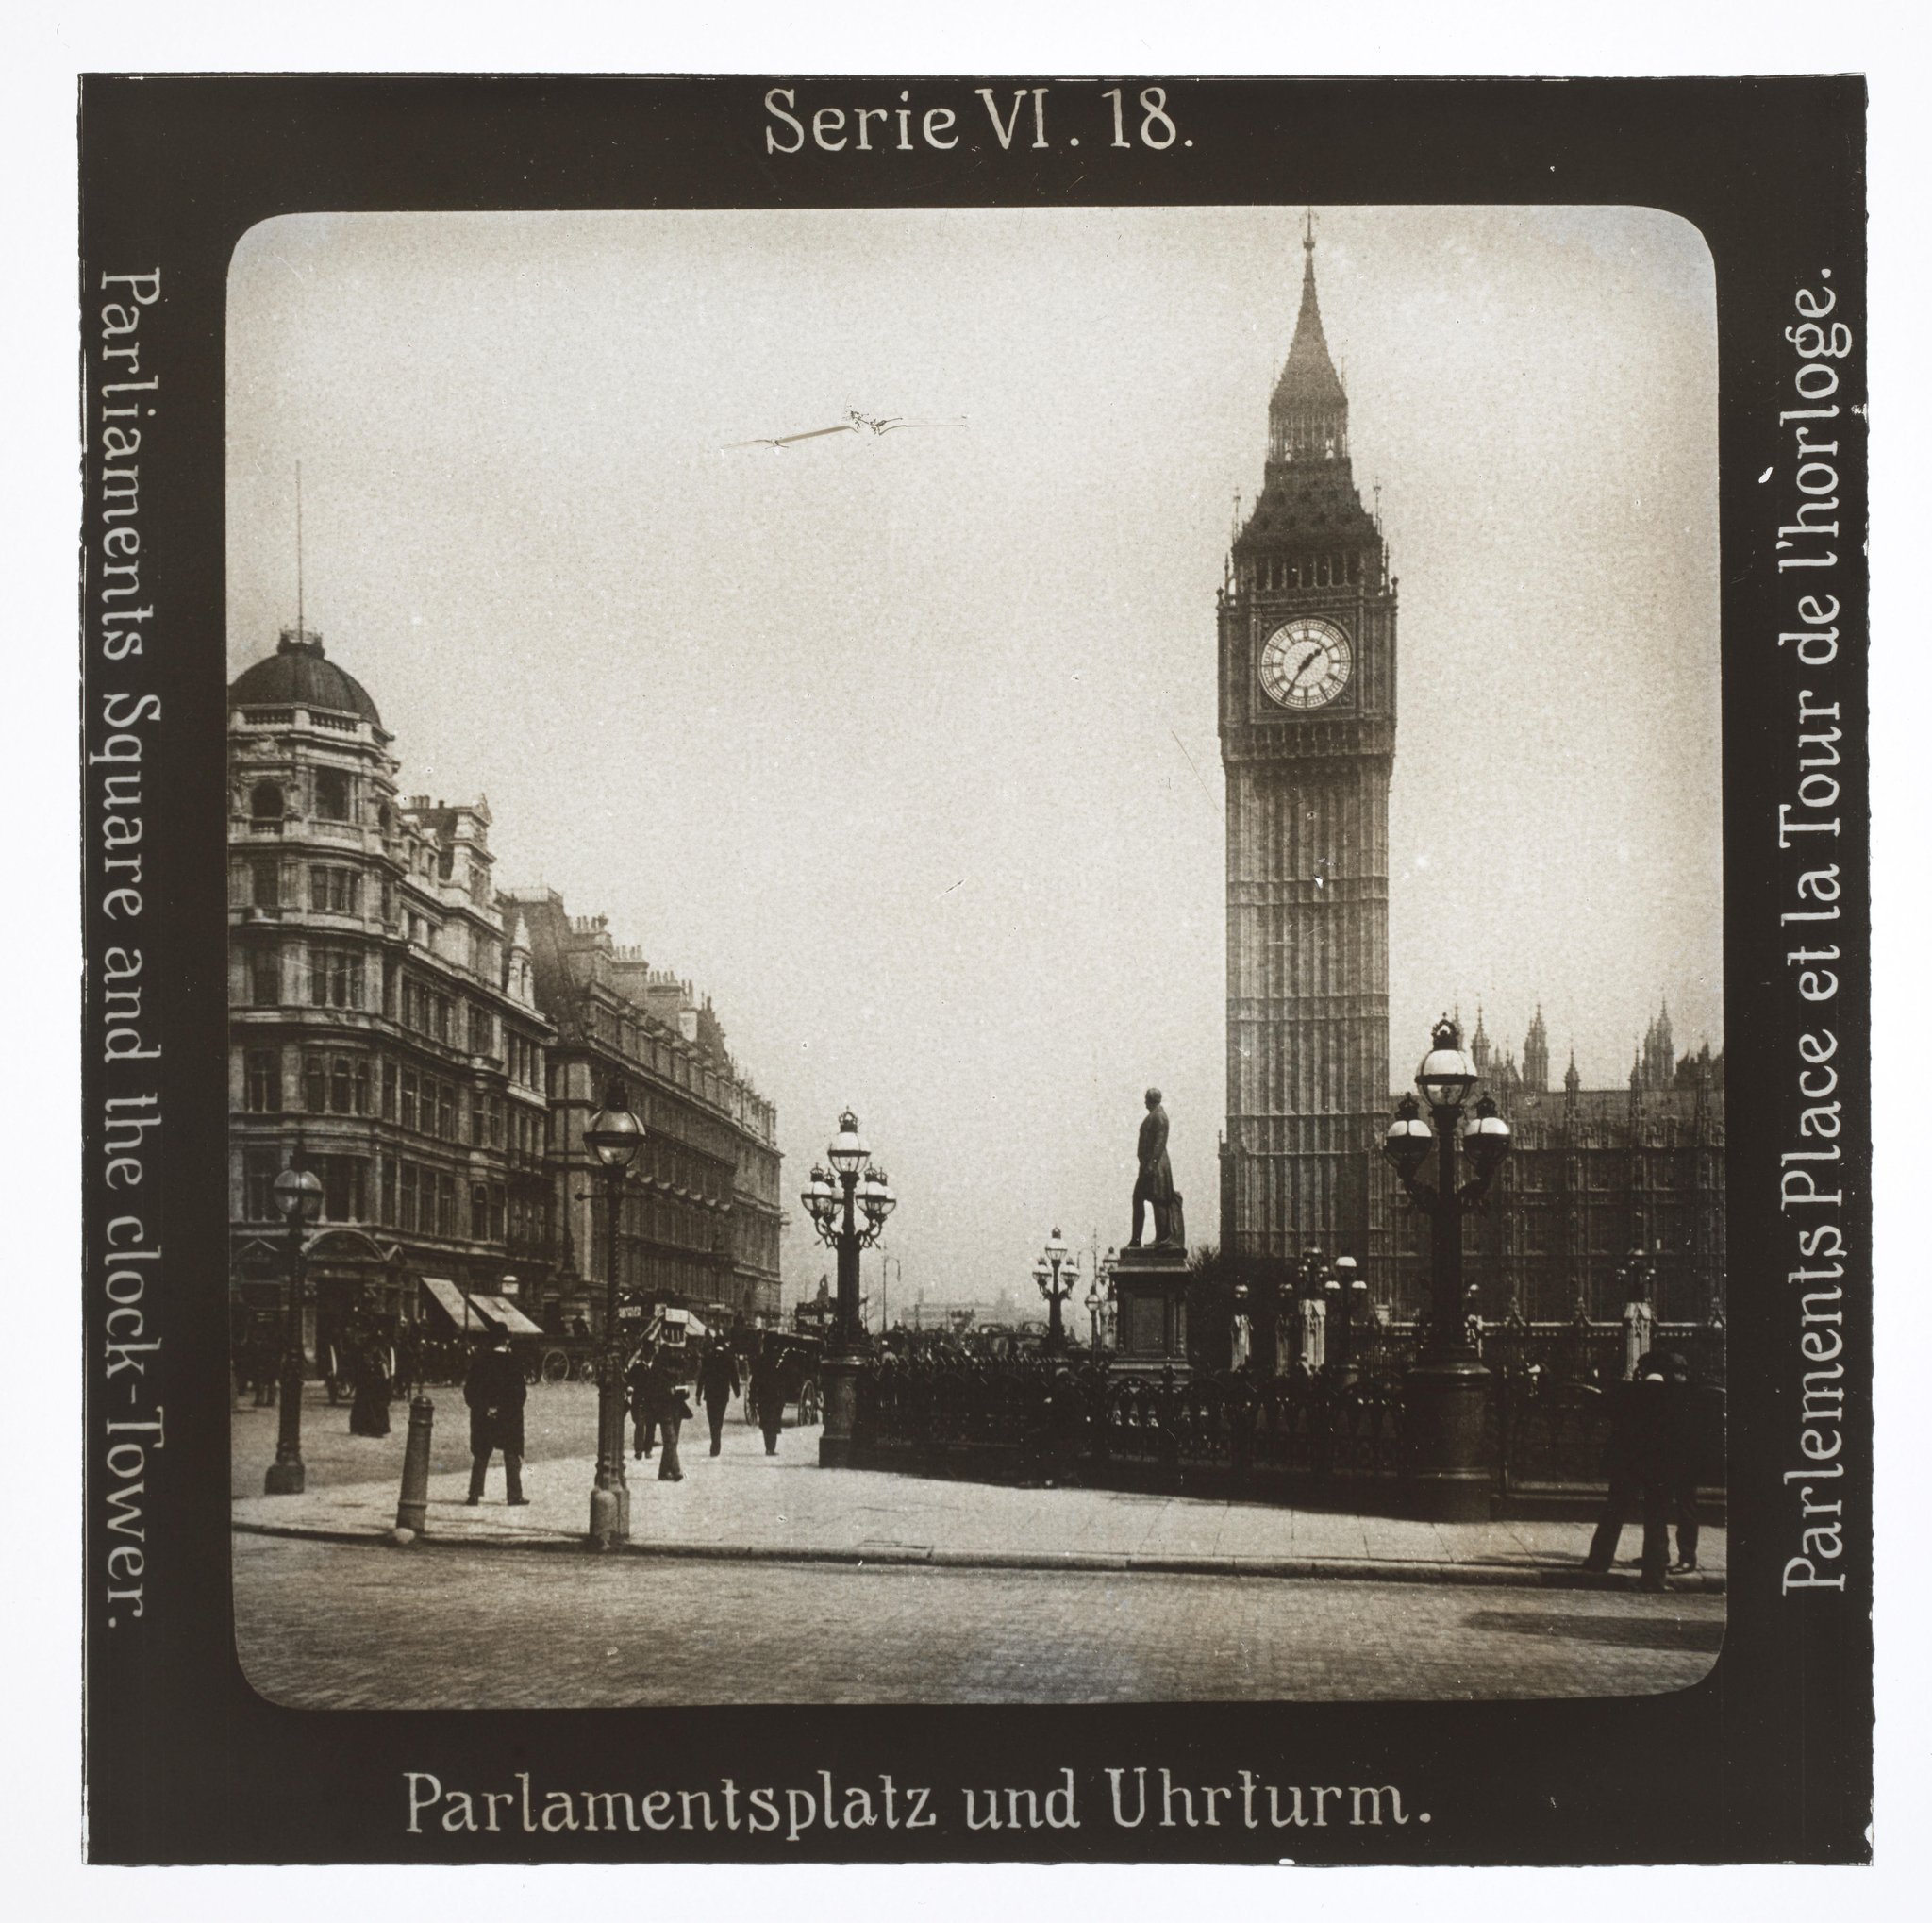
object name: lantern slide photographic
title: Gezicht op Parliament Square met de Big Ben klokkentoren van het Houses of Parliament te Londen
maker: Anonymous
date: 1900-1906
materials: glass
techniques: gelatin silver transparency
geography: london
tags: square, place, circus, etc., tower, clock tower ~ monumental adornment, façade (of house or building)